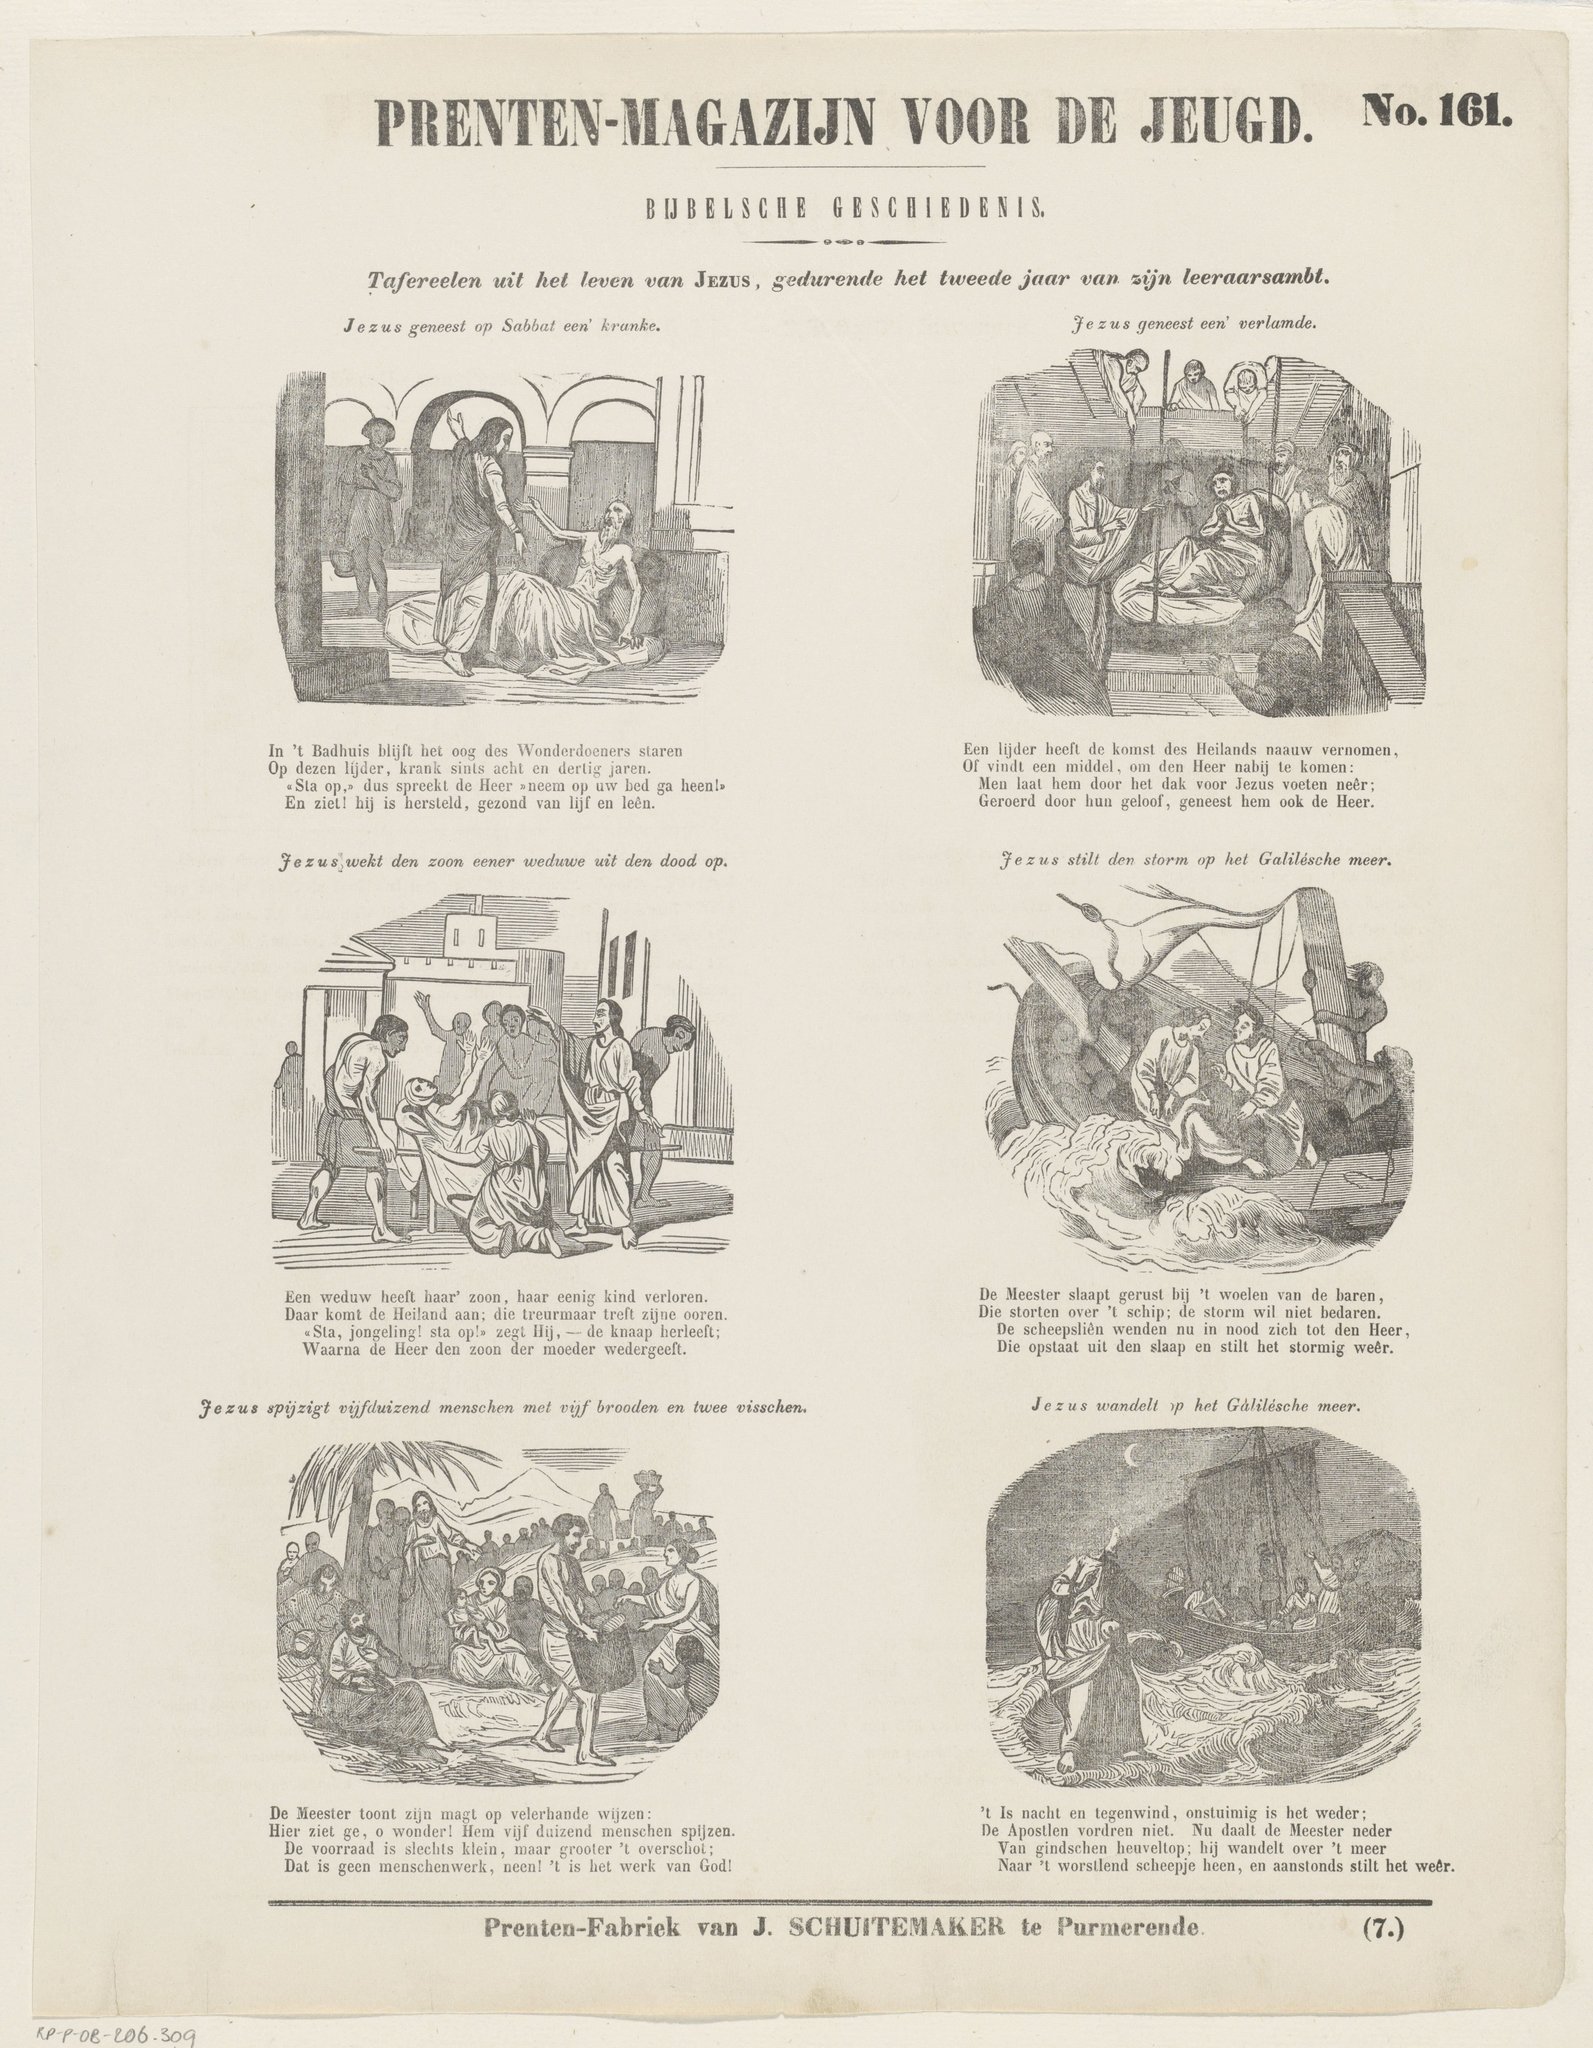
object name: print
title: Prenten-magazijn voor de jeugd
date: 1850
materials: paper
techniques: letterpress printing, engraving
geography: netherlands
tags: other healings by christ, multiplication of loaves and fishes for a multitude of four or five thousand people (matthew 14:13-21, 15:32-39; mark 6:32-44, 8:1-10; luke 9:10-17; john 6:1-14), new testament, series of scenes from the life of christ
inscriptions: collector's mark: Lugt 2760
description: Na voltooiing van de acht jaargangen van de reeks 'Prenten-magazijn voor de jeugd' in 1850 heeft Jan Schuitemaker al deze prenten heruitgegeven en omgenummerd als nr. 1 t/m 192. De oorspronkelijke jaargang wordt telkens nog vermeld rechtsonder op de prent. Binnen de jaargangen zijn prenten van hetzelfde thema in clusters van vier achter elkaar gezet.